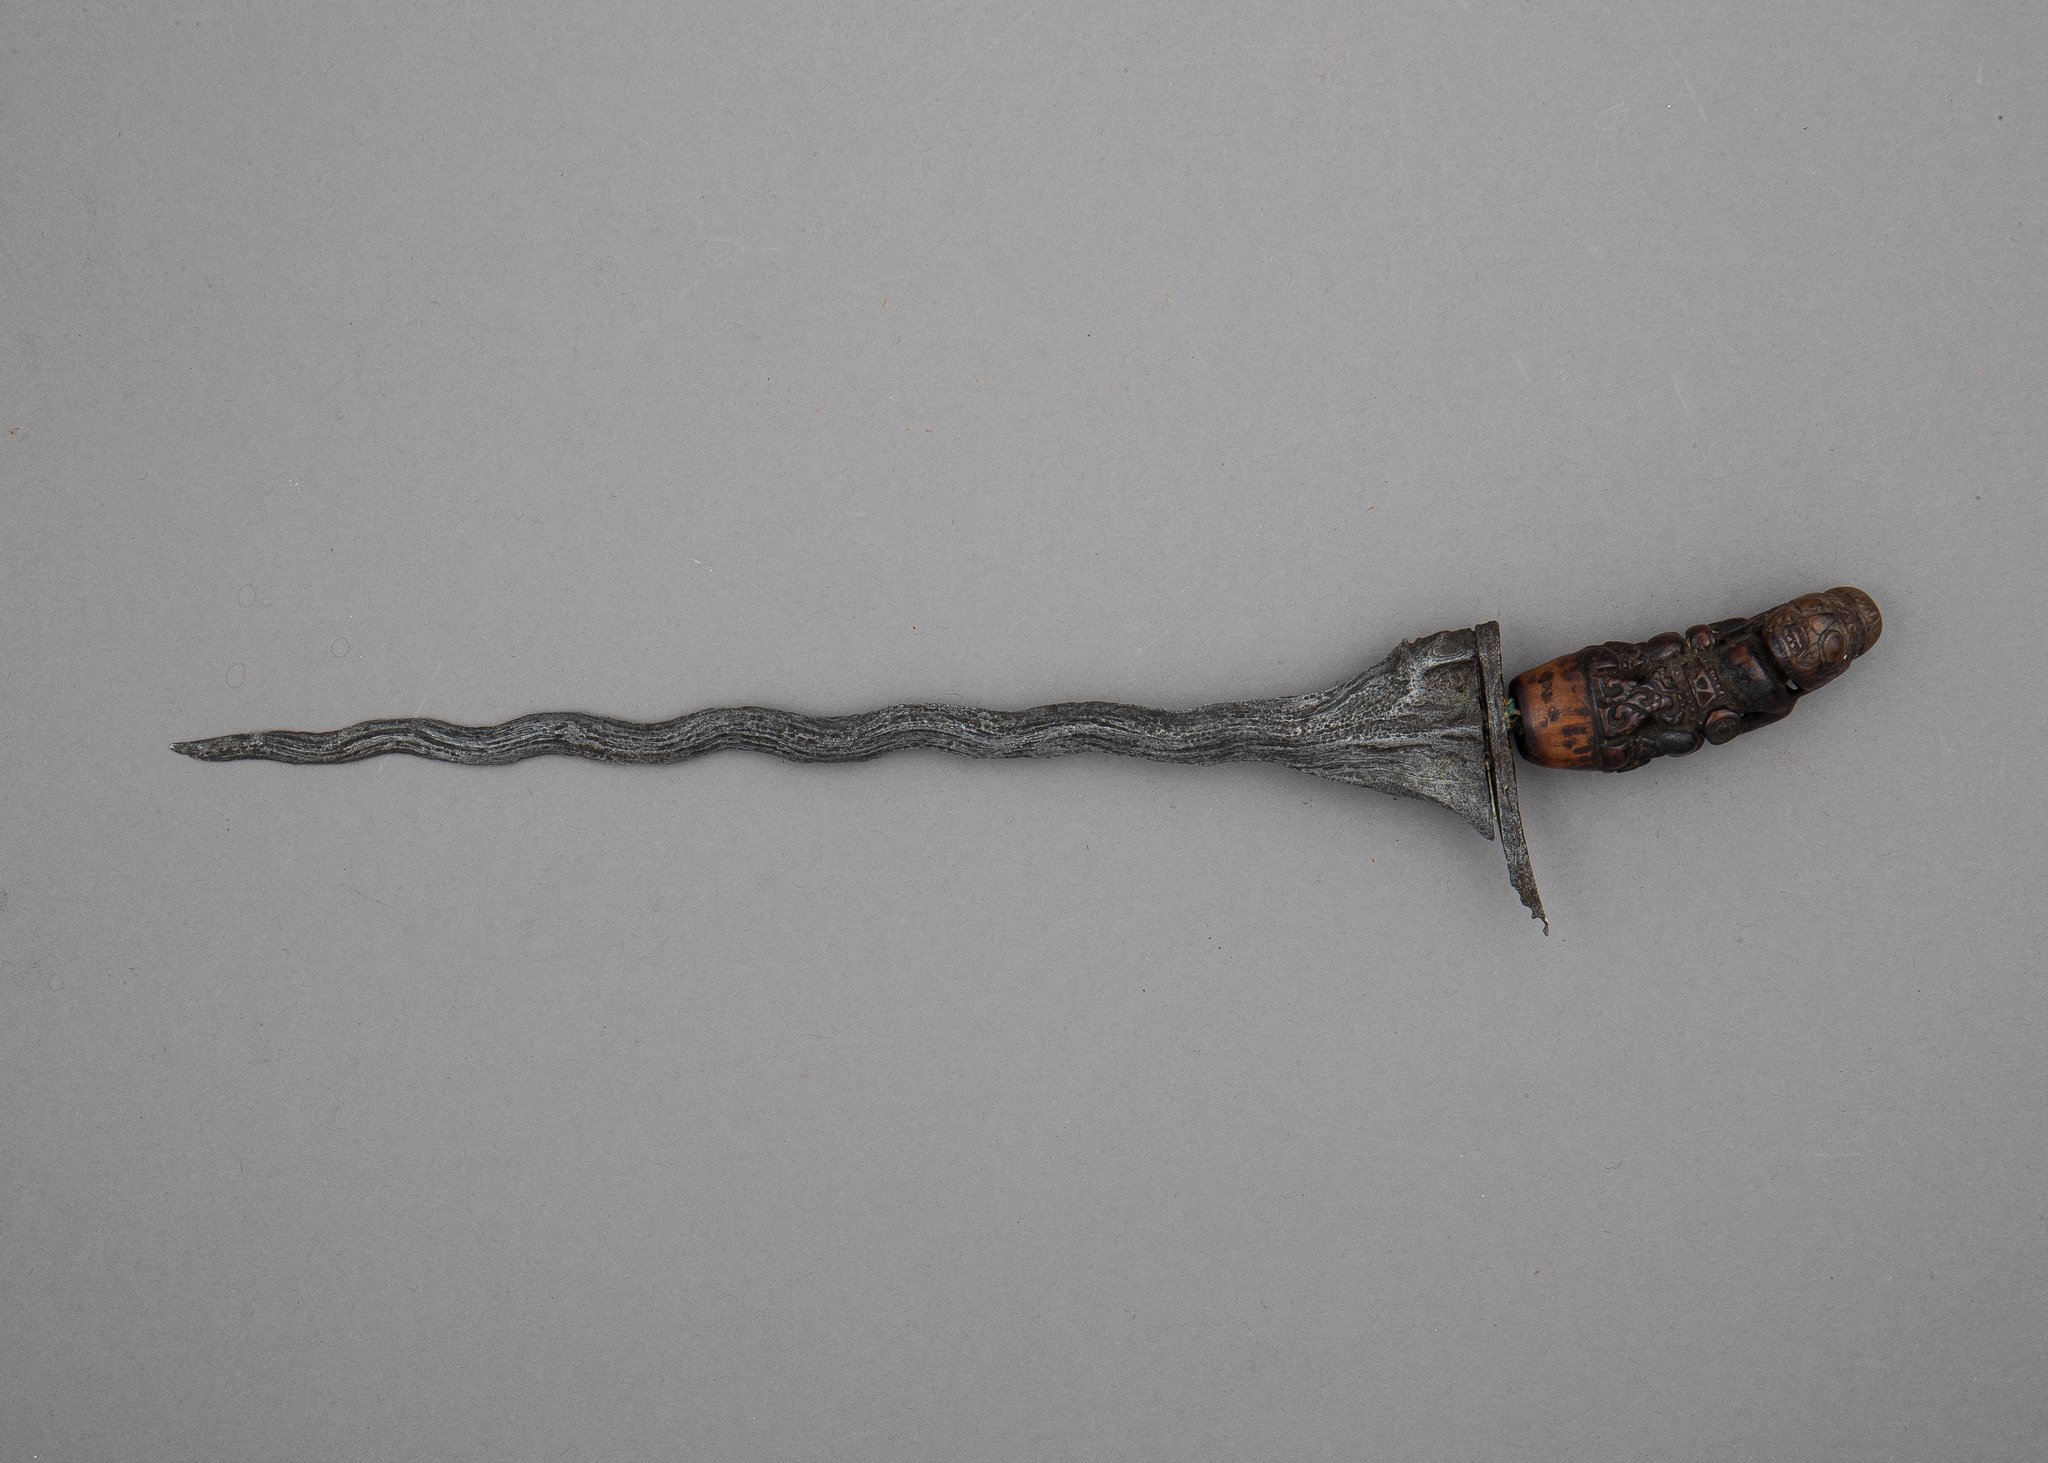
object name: kris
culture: javanese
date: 1501-1900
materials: steel, wood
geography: indonesia